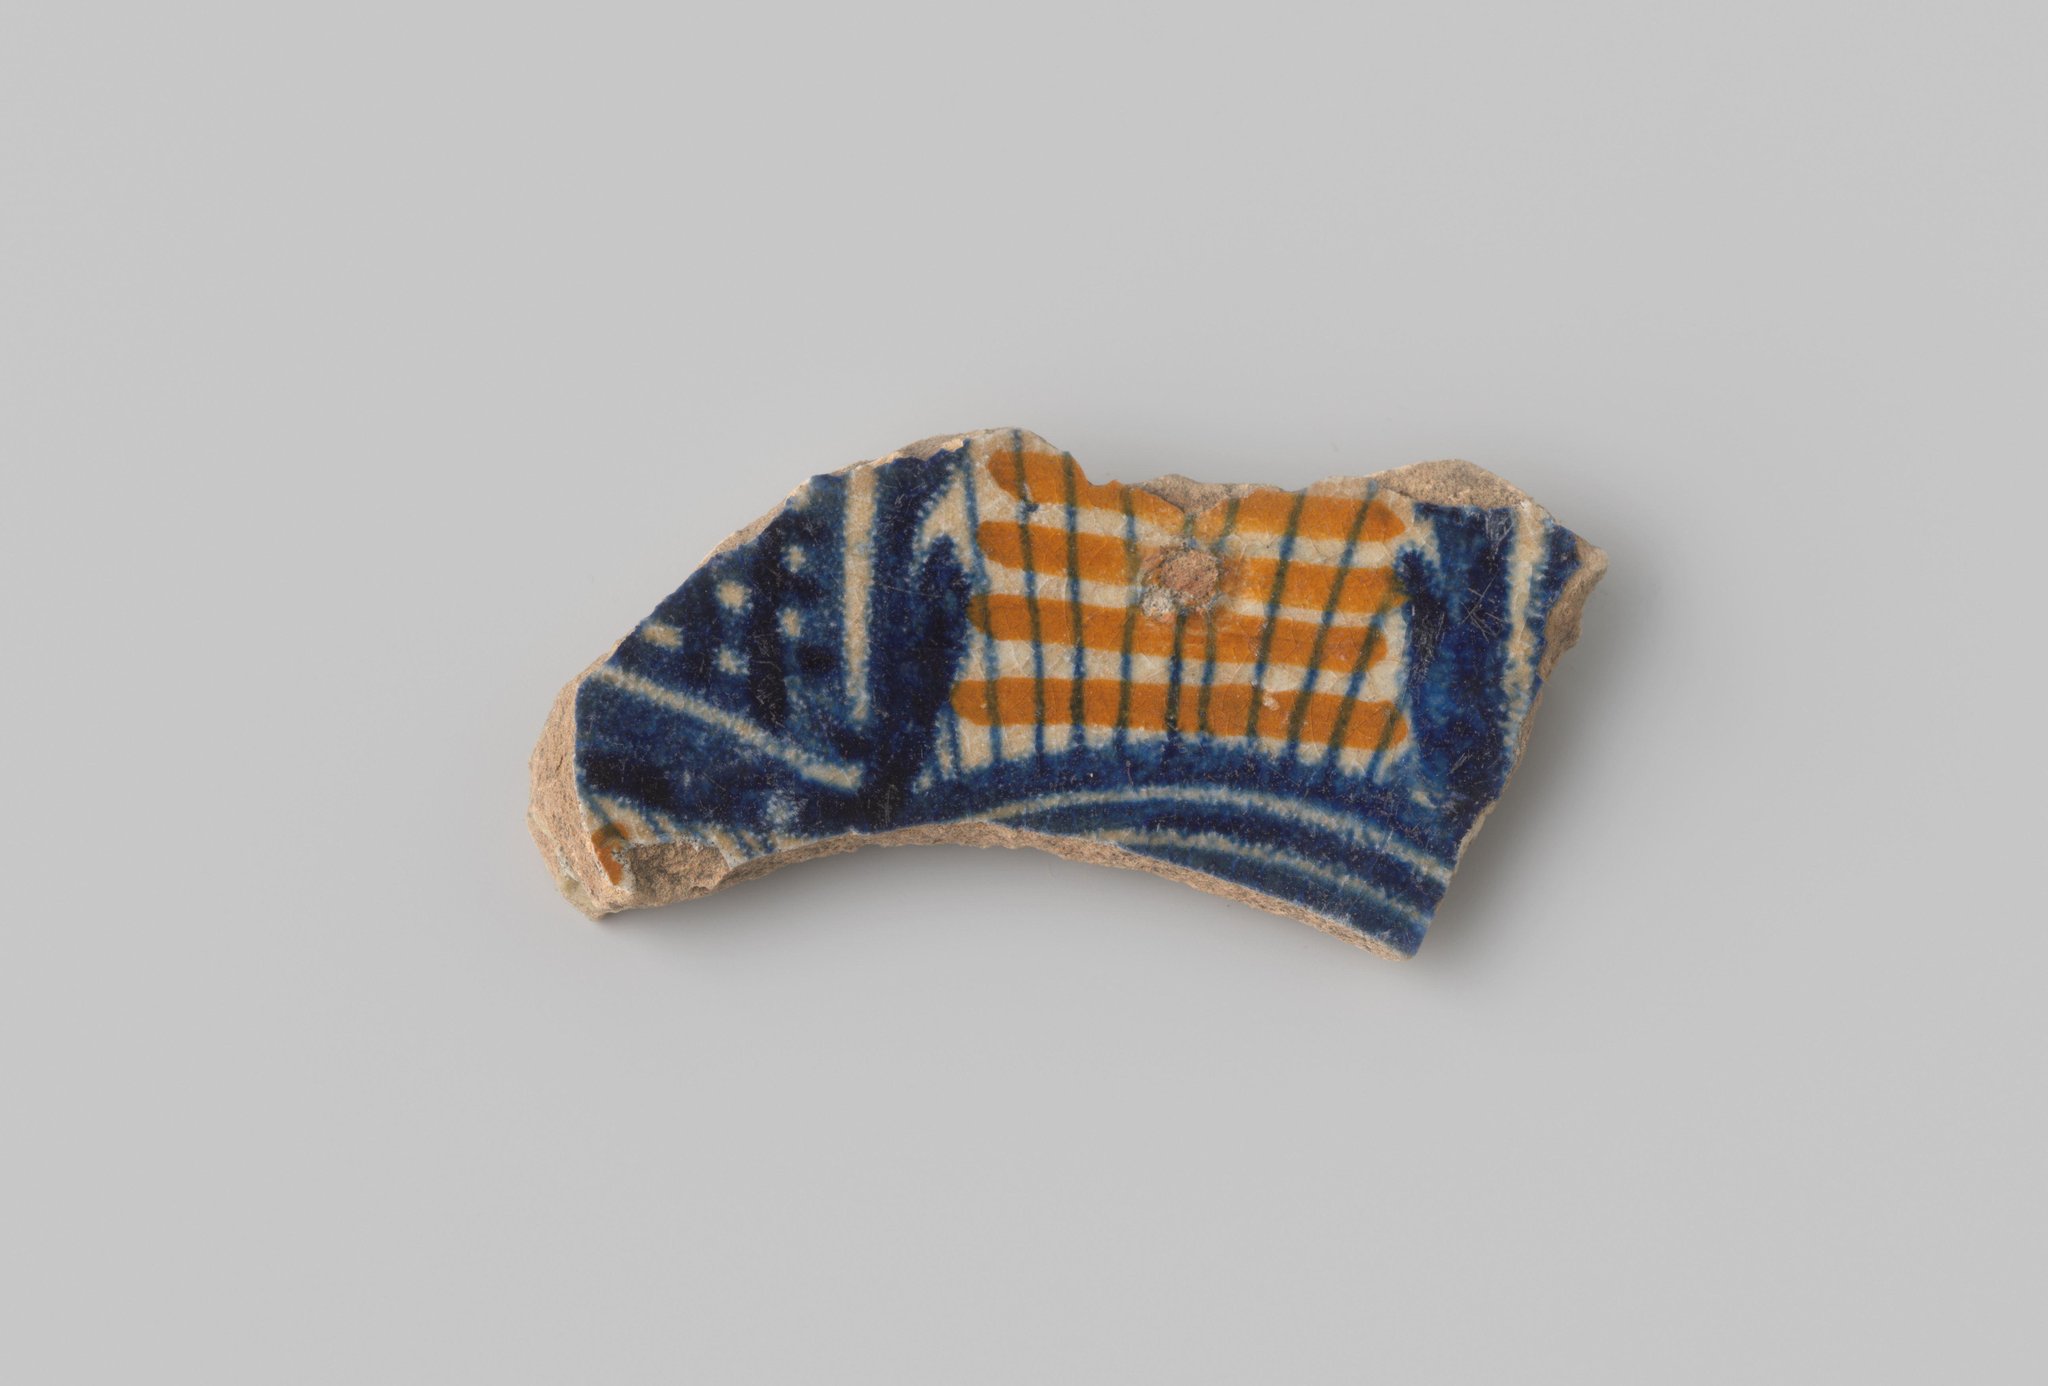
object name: sherd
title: Scherf veelkleurig majolica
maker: Anonymous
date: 1500-1699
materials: earthenware, glaze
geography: northern netherlands